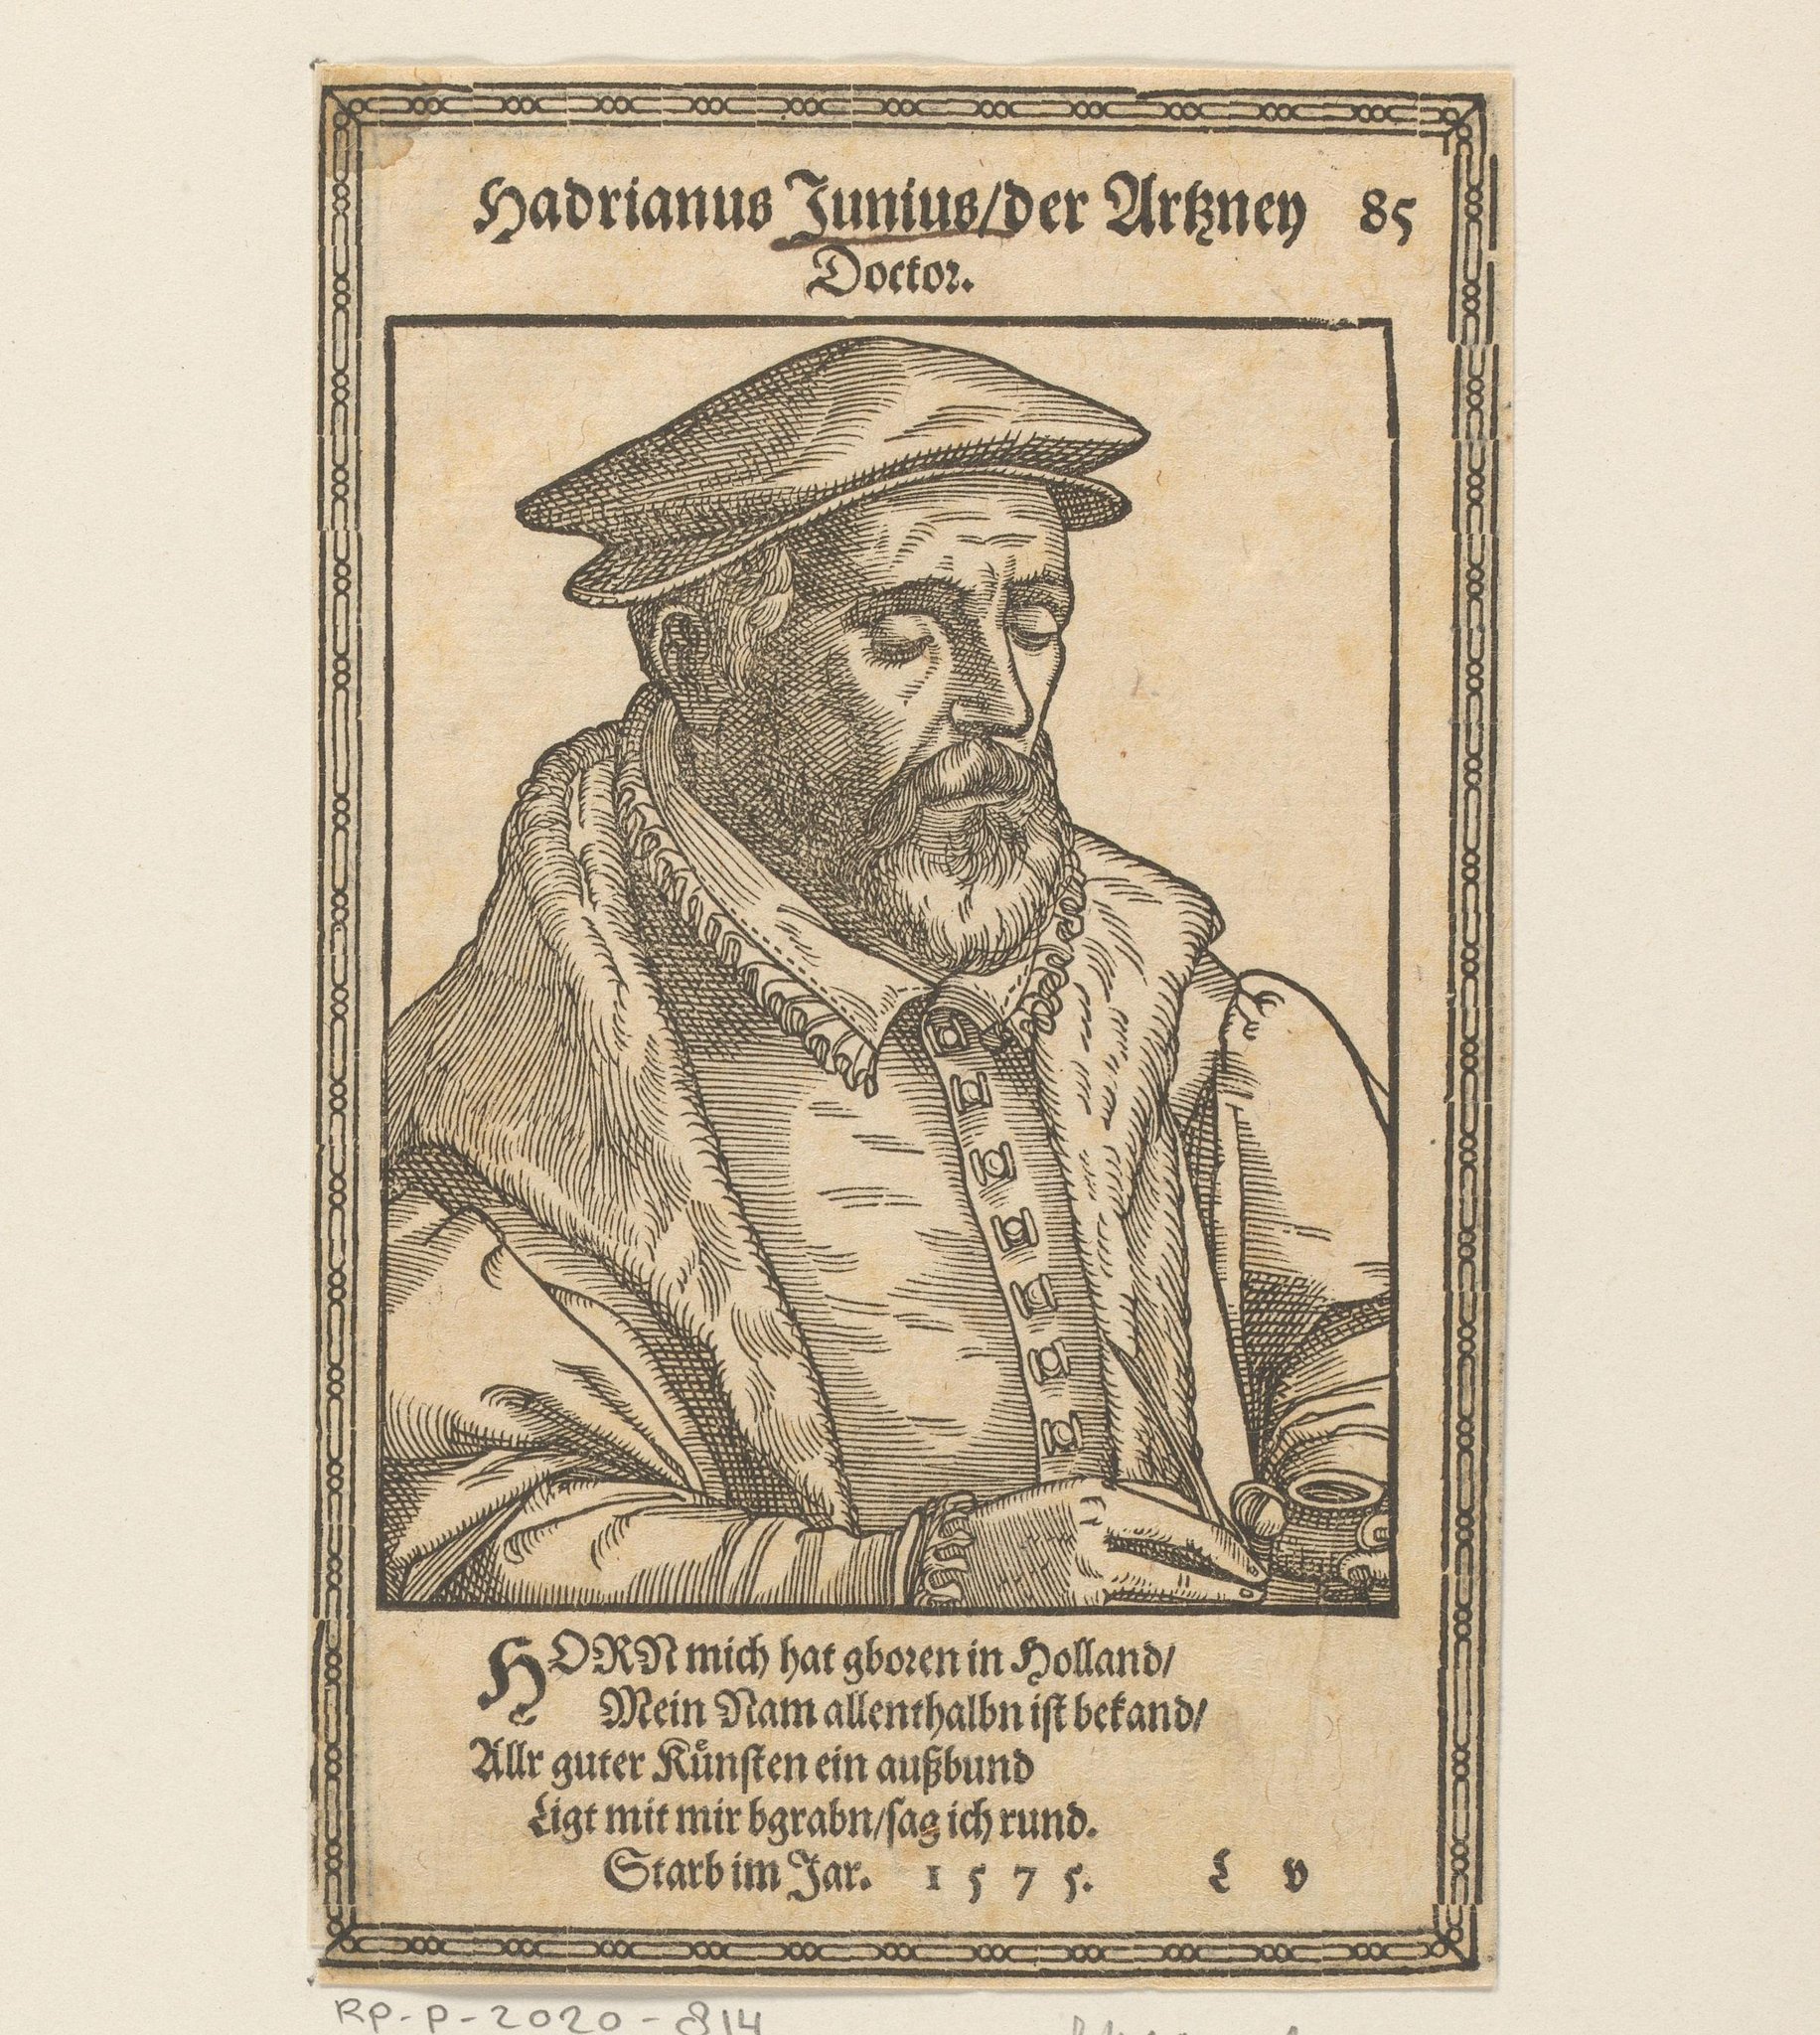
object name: book illustration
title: Portret van Hadrianus Junius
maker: bernhard jobin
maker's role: printer, publisher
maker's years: 1545-1593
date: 1587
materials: paper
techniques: letterpress printing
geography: straatsburg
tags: hoorn (north holland), middelburg, hadrianus junius, historical persons, physician, doctor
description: Prent uit: Reusner, Nikolaus. Contrafacturbuch: ware und lebendige Bildnussen etlicher weitberhümbten unnd hochgelehten Männer in Teutschland. Straatsburg: Bernhard Jobin, 1587, f. 85. Prent ook gebruikt in de Latijnse editie, uitgegeven in hetzelfde jaar, en de 1590-editie. Prent ook gebruikt in latere publicaties.